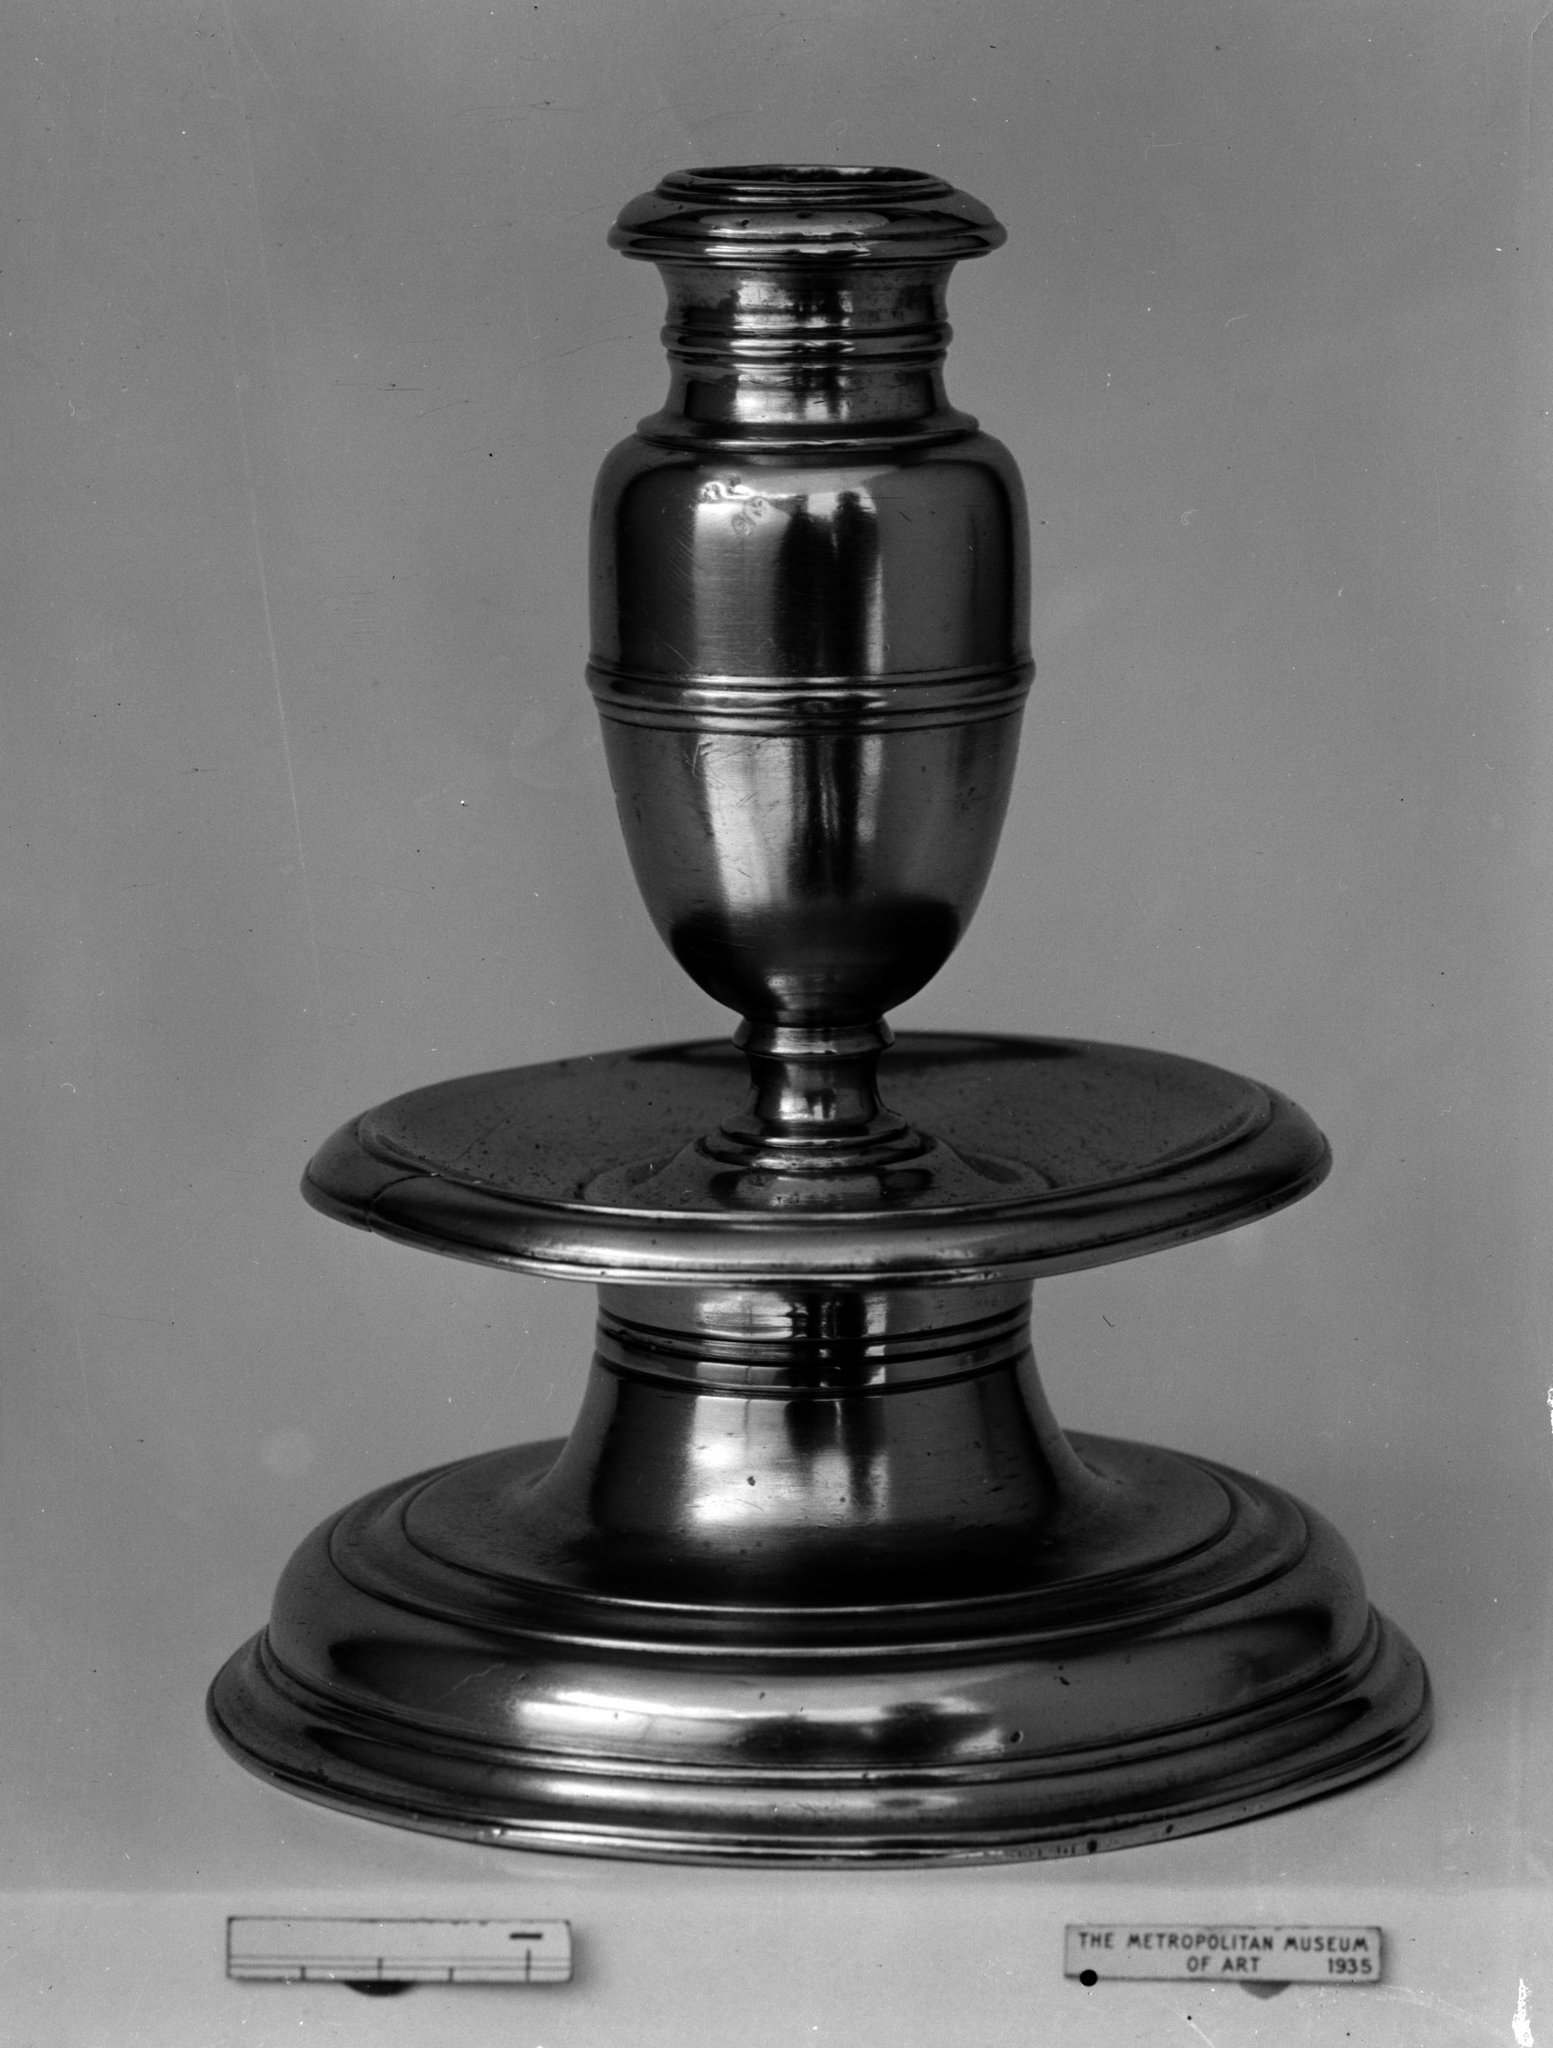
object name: candlestick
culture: british or flemish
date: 1630-1670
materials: brass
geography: belgium